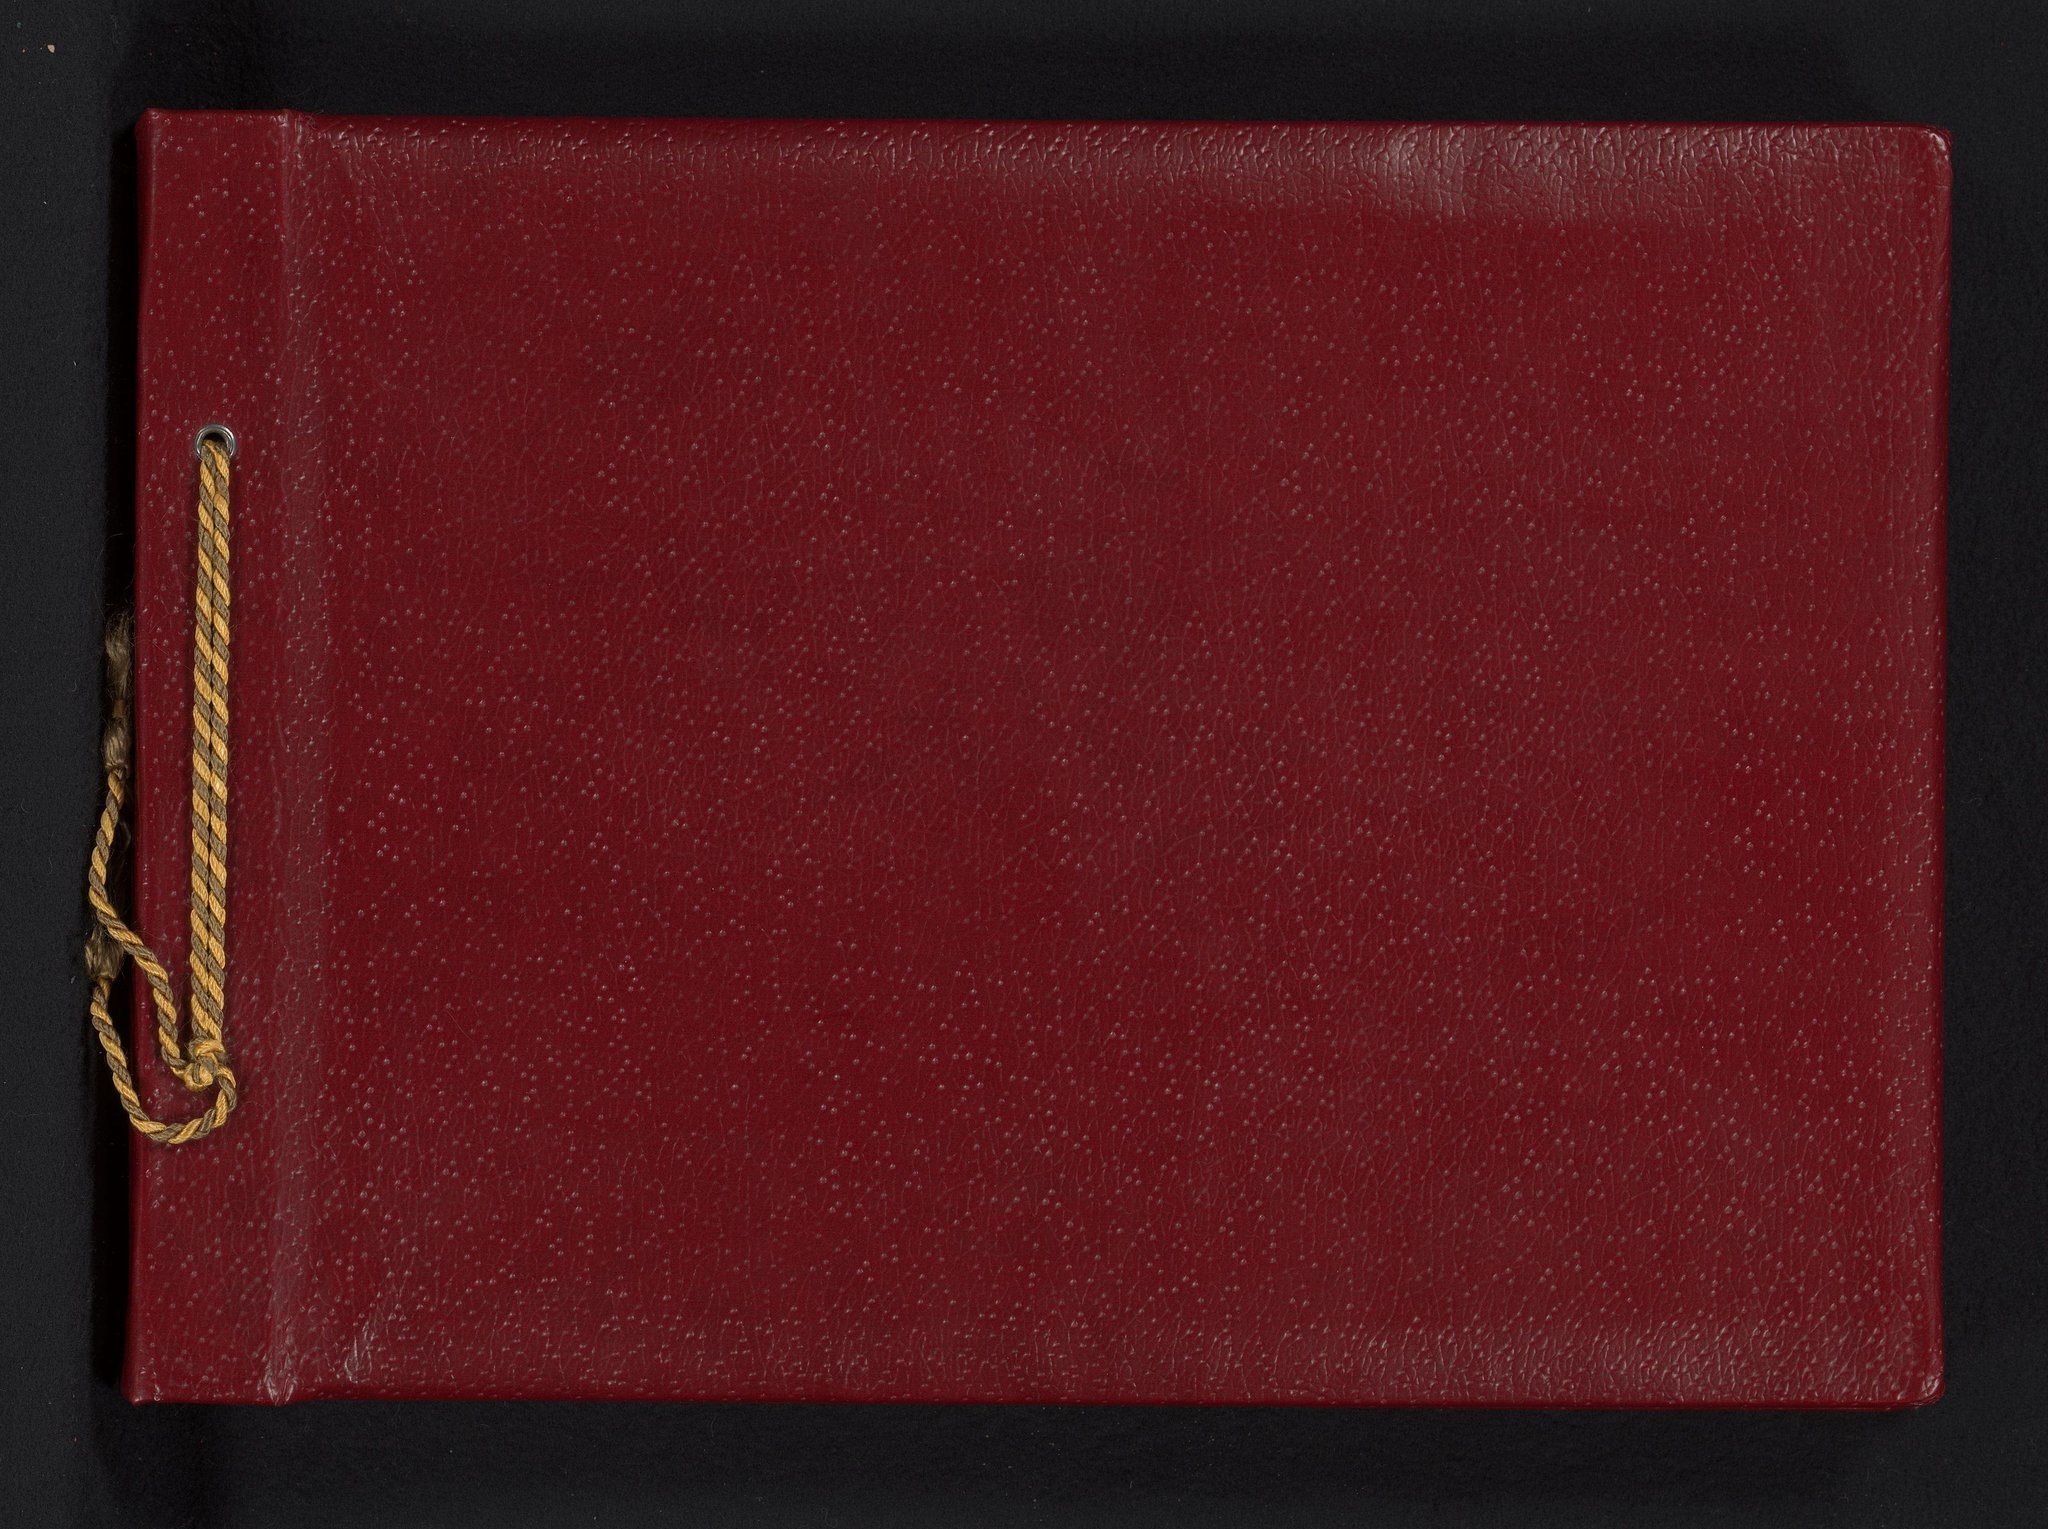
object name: photograph album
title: Fotoalbum Wehrmacht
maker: Anonymous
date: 1939-1943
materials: leather, paper, photographic support, textile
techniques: gelatin silver print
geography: hungary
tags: france, gelderland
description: Duits militair fotoalbum uit de Tweede Wereldoorlog over soldaten van de Wehrmacht. Donkerrode kunstleren omslag met een koordje door de rug. Het binnenwerk bestaat uit 18 (moderne) grijze bladen met (modern) vloeipapier ertussen. Sommige bladen zijn leeg. De 119 foto's tonen de opleiding bij de Arbeidsdienst in Duitsland (Hamm) tot blz. 8, na 1940 legering in Gelderland, vanaf blz. 9, Frankrijk, Biarritz en andere plaatsen (blz. 11 e.v. ) en Hongarije vanaf blz. 22. Tussendoor weer mogelijk terug in Nederland, blz.18. Laatste foto met opschrift: Otto's Grab, 1943.